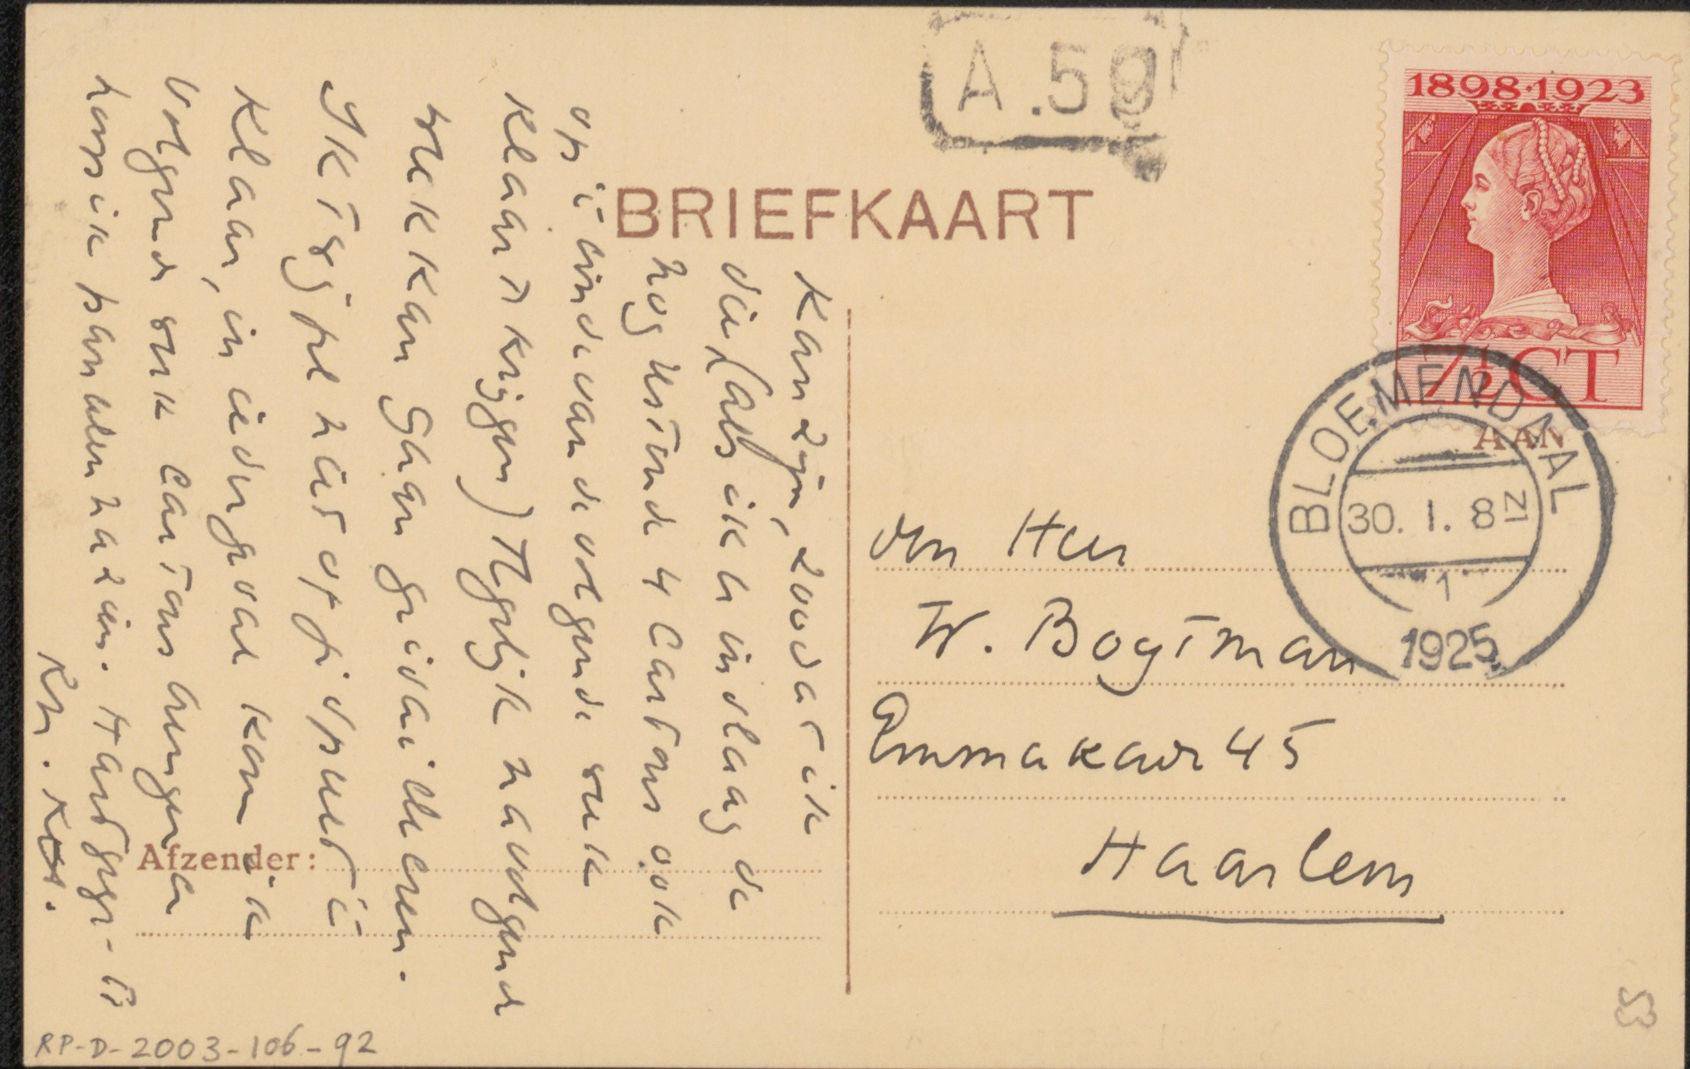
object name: postcard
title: Briefkaart aan Willem Bogtman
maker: richard nicolaüs roland holst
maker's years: 1868-1938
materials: cardboard, ink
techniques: pen, writing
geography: bloemendaal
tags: haarlem, willem bogtman, drawing, applied arts, arts and crafts; industrial design, workshop, studio of the artist (in general)